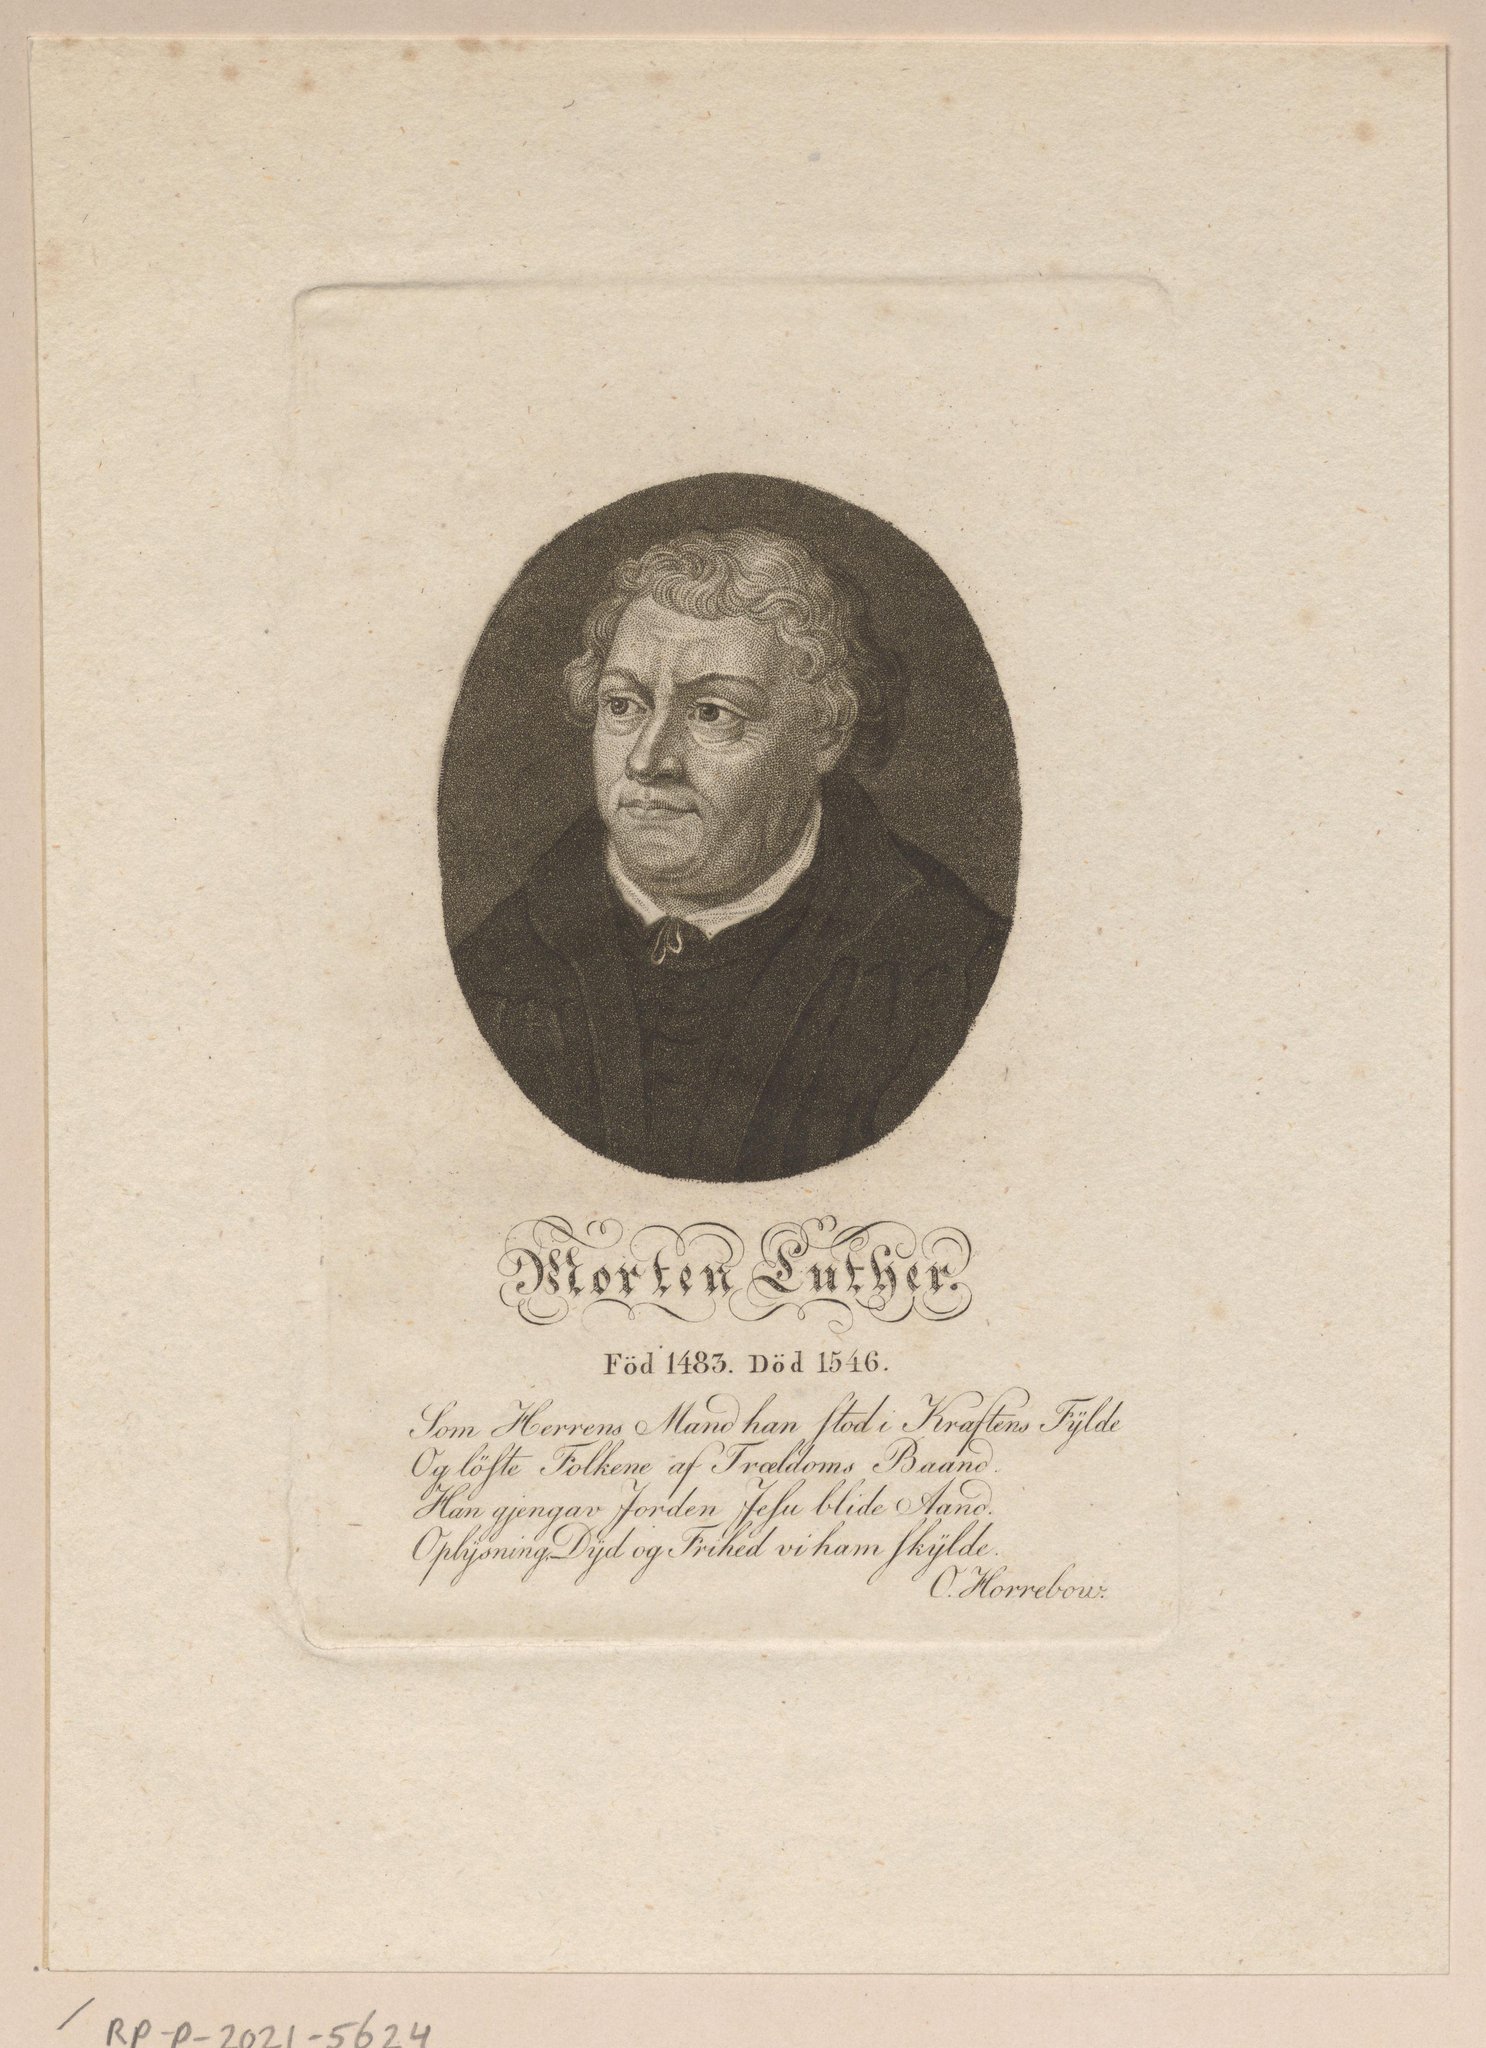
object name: print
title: Portret van Martin Luther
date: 1740-1799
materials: paper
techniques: stippling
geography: denmark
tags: priest, martin luther, theologian, historical persons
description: Met vierregelig vers in het Deens onder het portret.